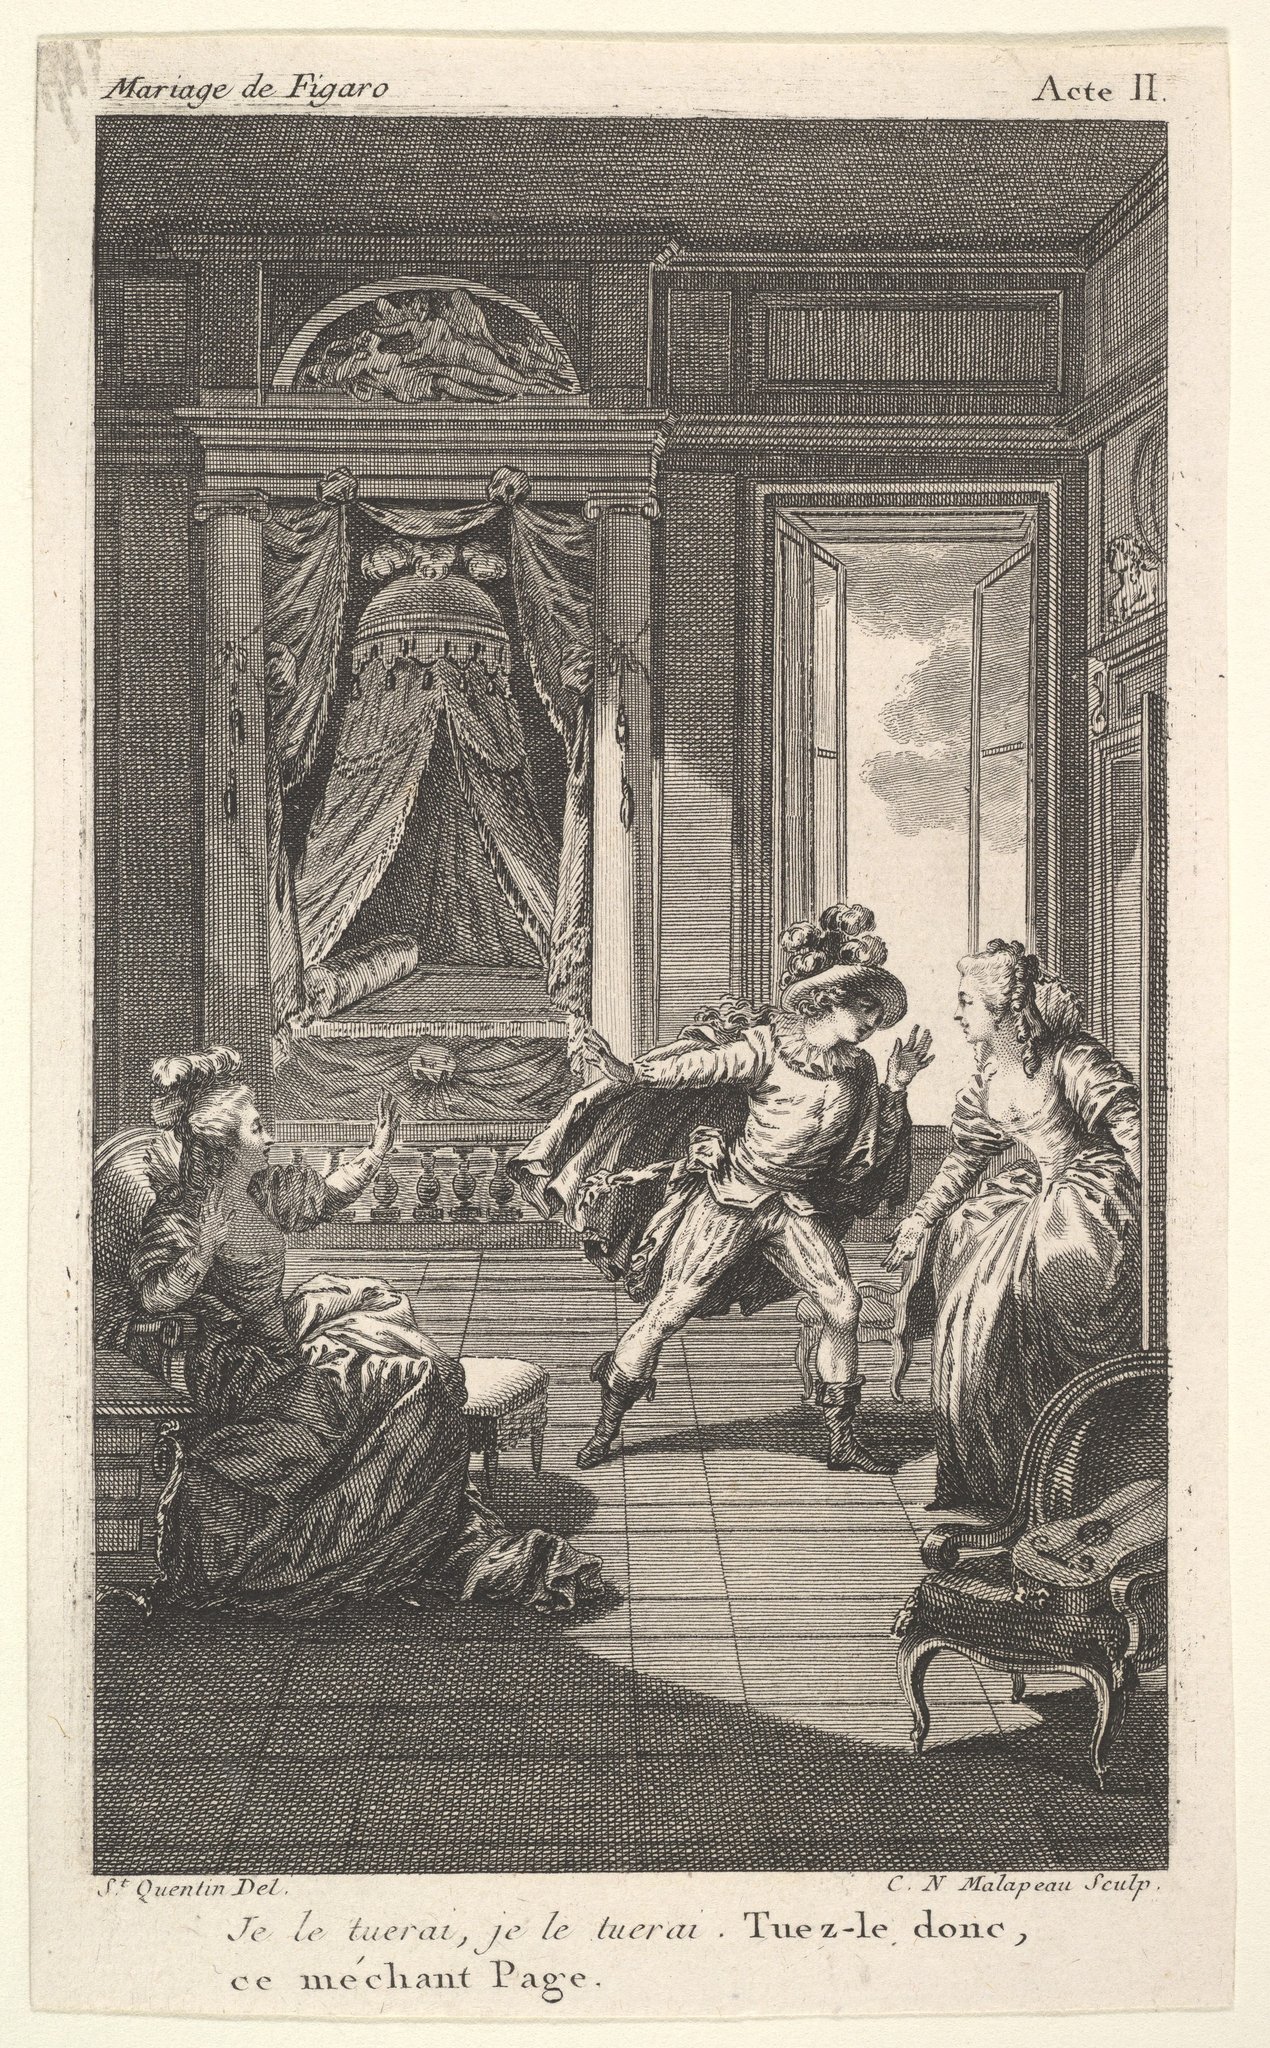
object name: print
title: A man leans toward a woman standing in a doorway at right, at left a seated woman raises both hands, a canopied bed beyond, from a series of five illustrations after Jacques Philippe Joseph de Saint-Quentin for 'The mad day, or the marriage of Figaro' (La Folle journée, ou le mariage de Figaro) by Pierre Augustin Caron de Beaumarchais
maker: jacques philippe joseph de saint quentin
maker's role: artist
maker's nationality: french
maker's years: 1738-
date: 1784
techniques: engraving, etching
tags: doorways,men,women